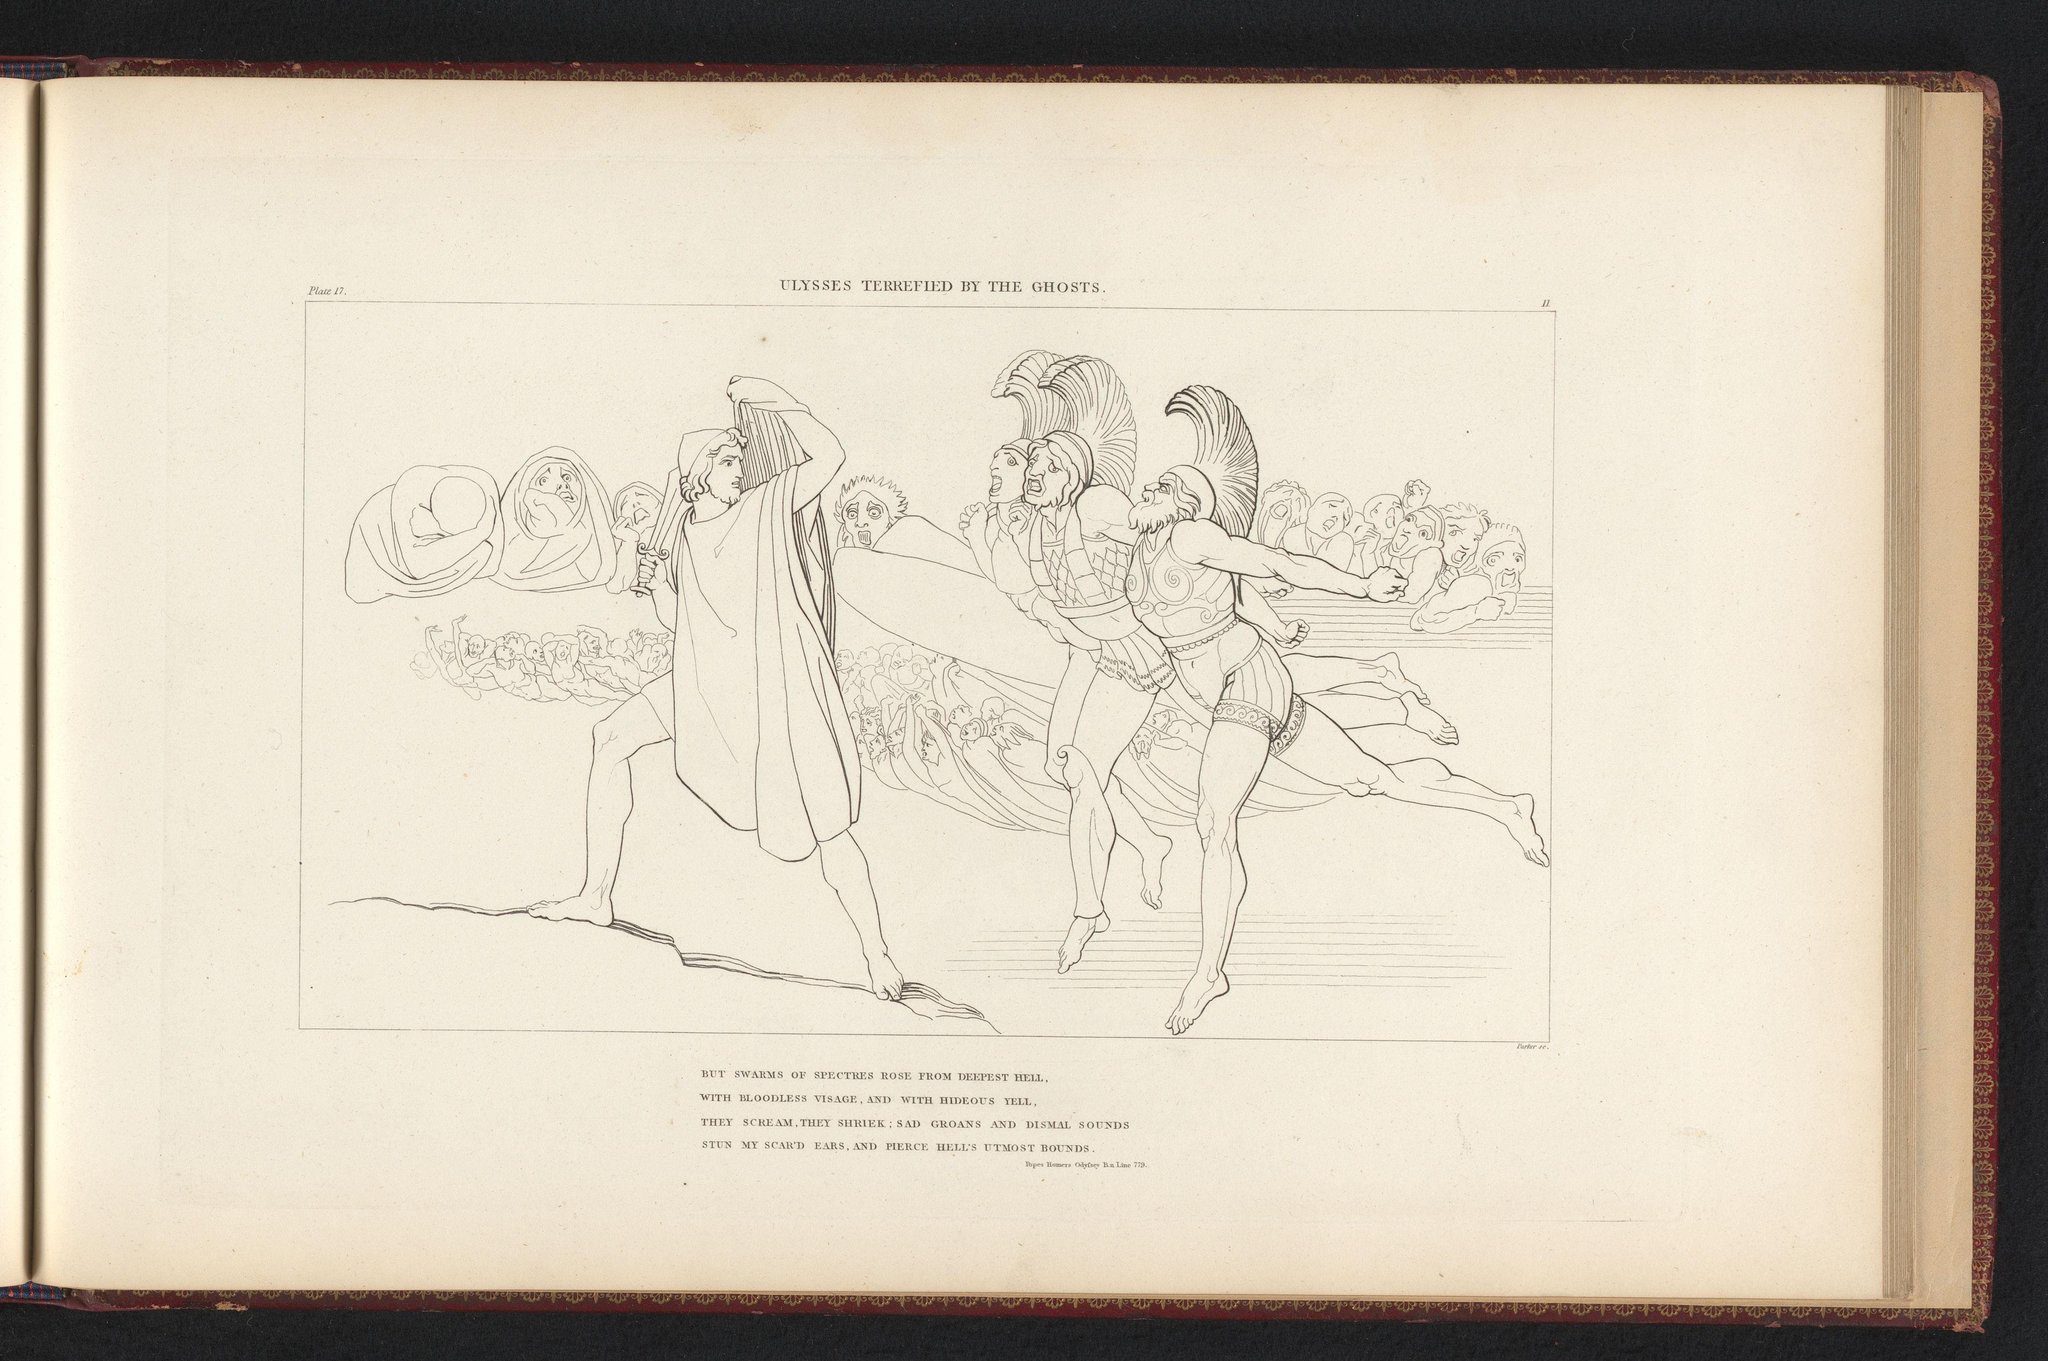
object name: album leaf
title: Odyssee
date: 1805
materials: paper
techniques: etching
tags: ulysses, waiting sword in hand, sees the ghost of elpenor (+ variant)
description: Prent maakt onderdeel uit van een serie met 34 prenten over de Odyssee, geschreven door Homerus.